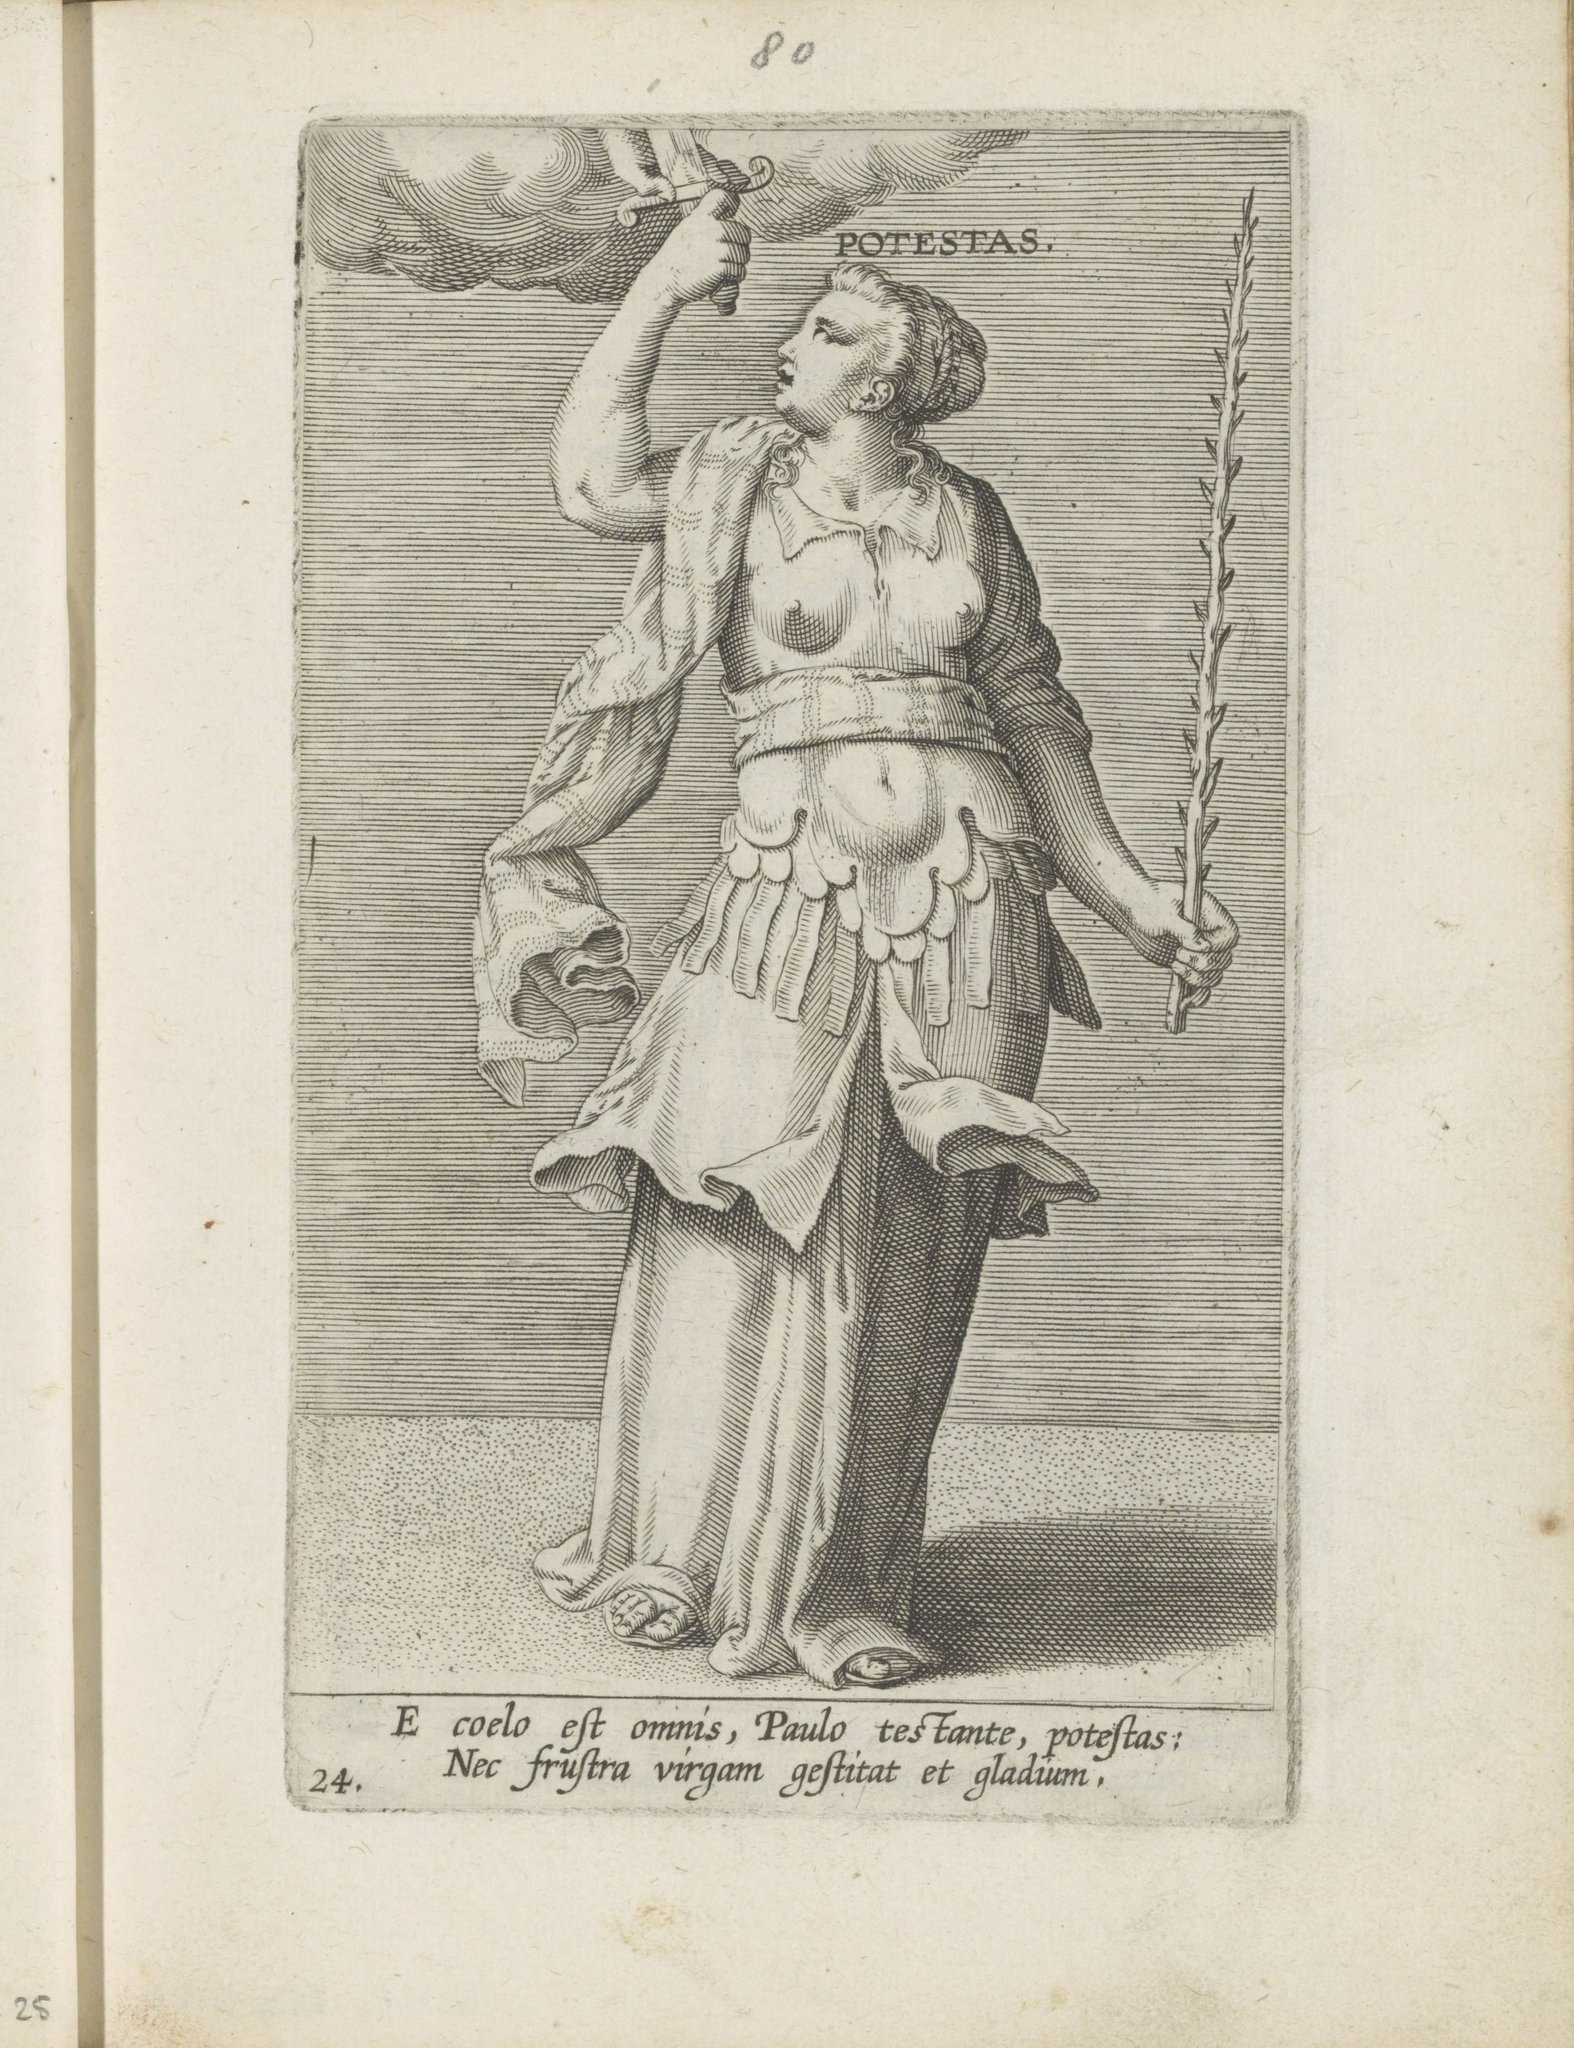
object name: print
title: Bevoegdheid of Vermogen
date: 1585-1590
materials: paper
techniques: engraving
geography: antwerp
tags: power, 'potestas' ~ one of the seven gifts of the soul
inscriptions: collector's mark: Lugt 2760, collector's mark: Lugt 2228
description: Een staande vrouw. Een hand vanuit de lucht reikt haar een zwaard aan. In haar linkerhand heeft ze een tak met doornen. Onder de voorstelling twee regels tekst in het Latijn. De prent maakt deel uit van een album.